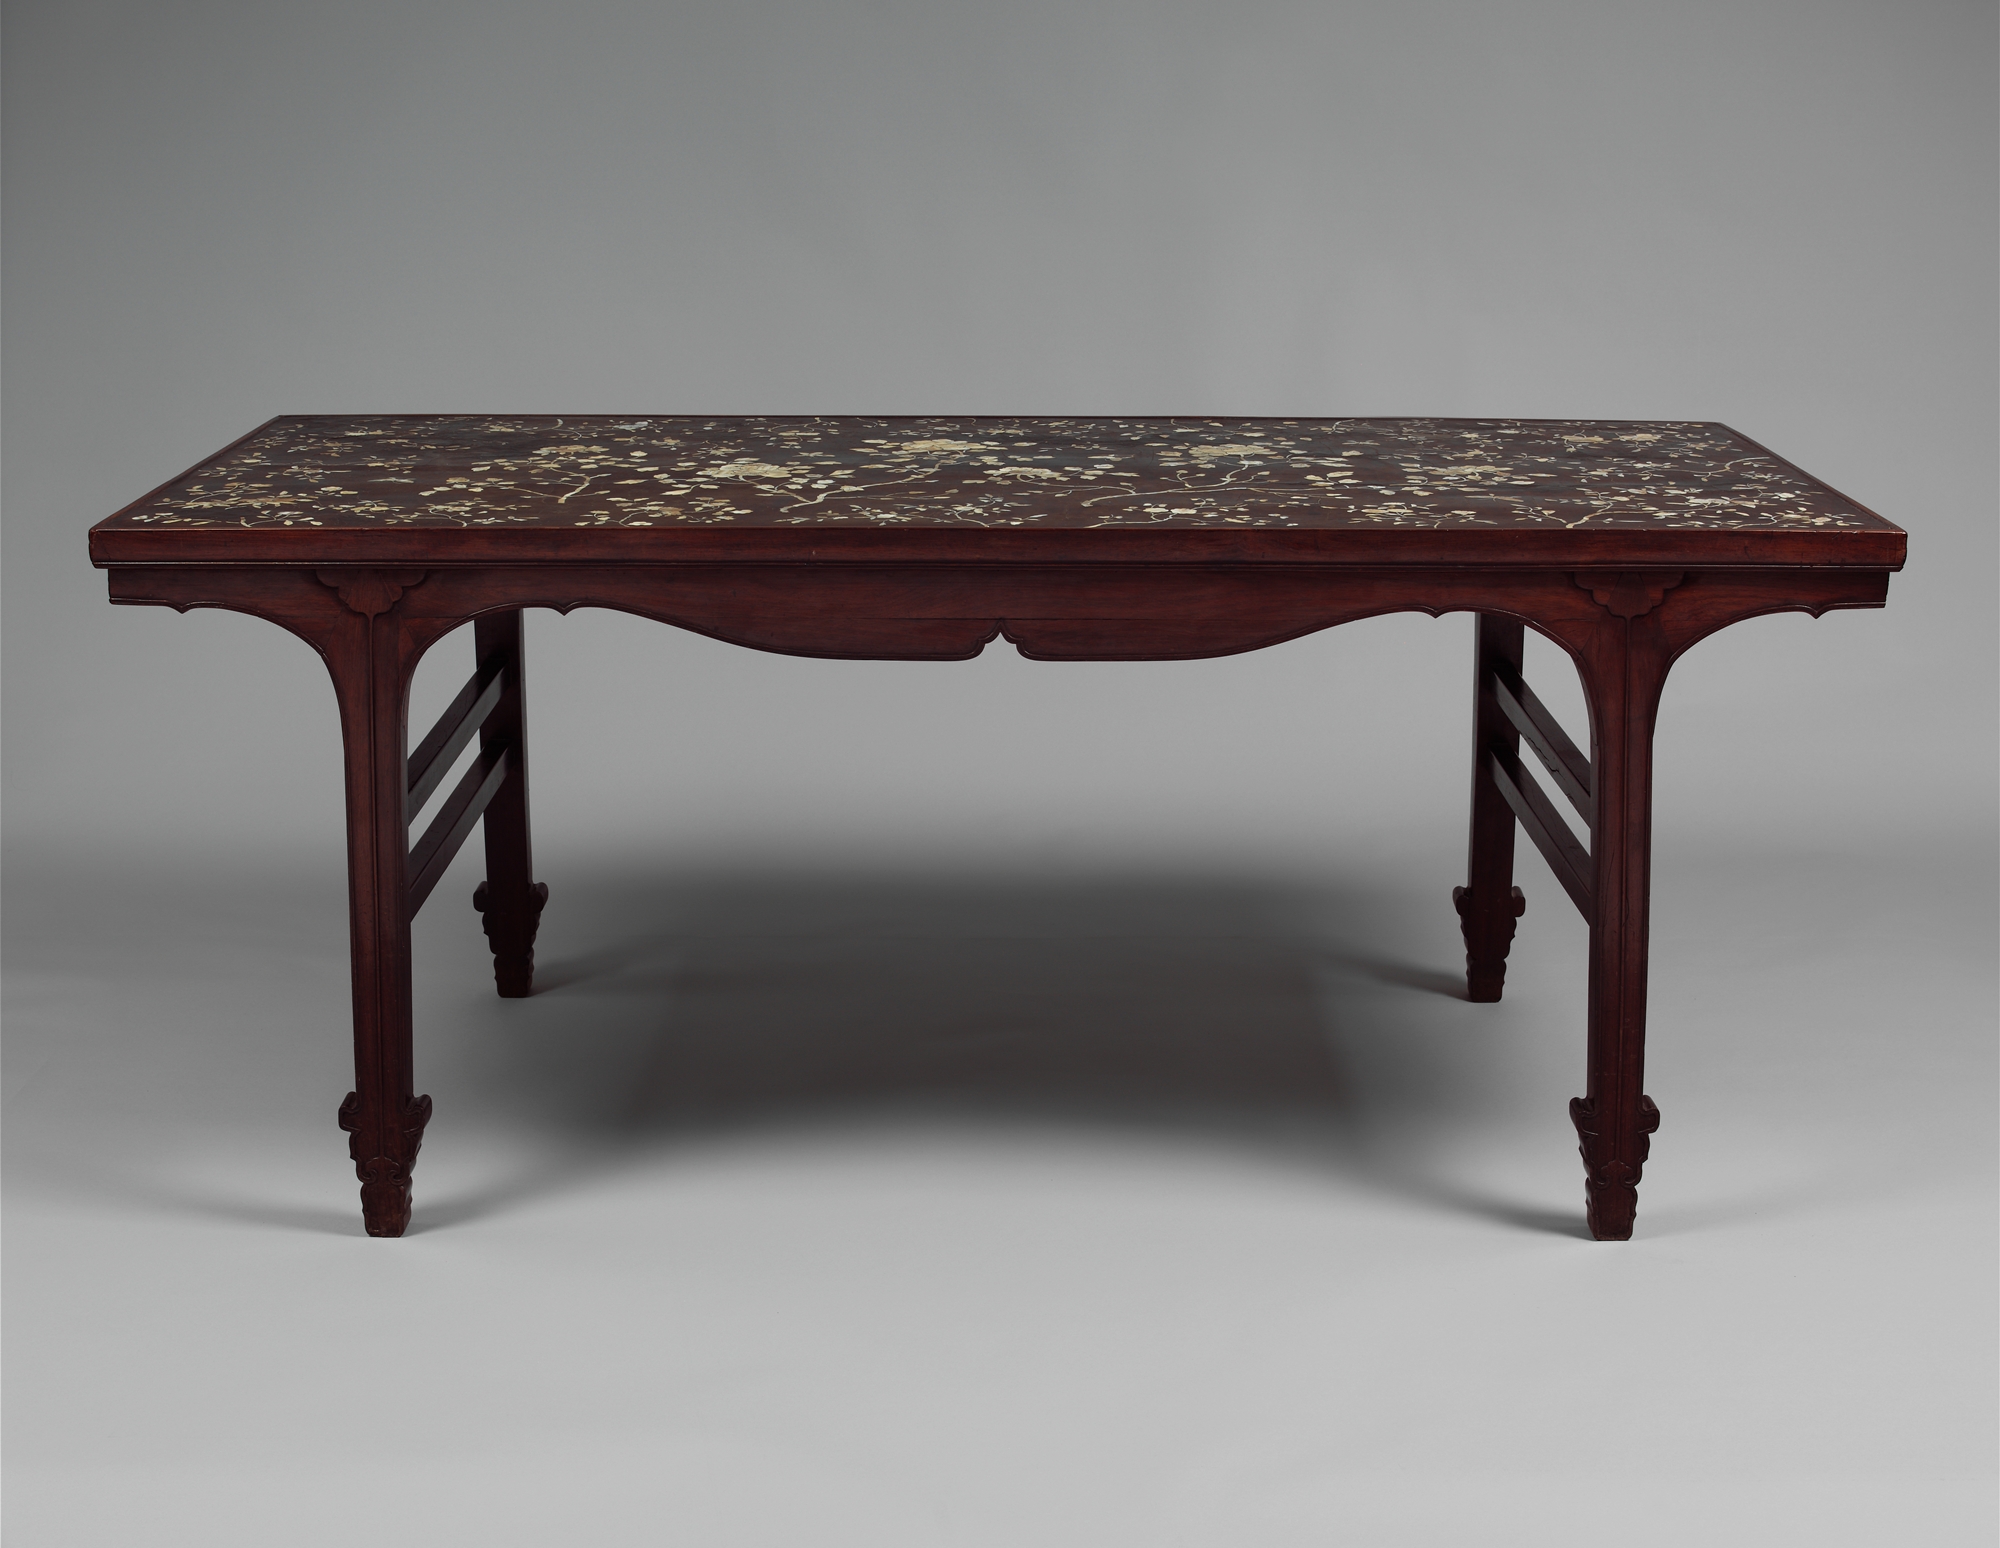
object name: table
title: Table with Flowering Sprays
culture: chinese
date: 1567-1633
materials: lacquer, mother of pearl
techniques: inlay